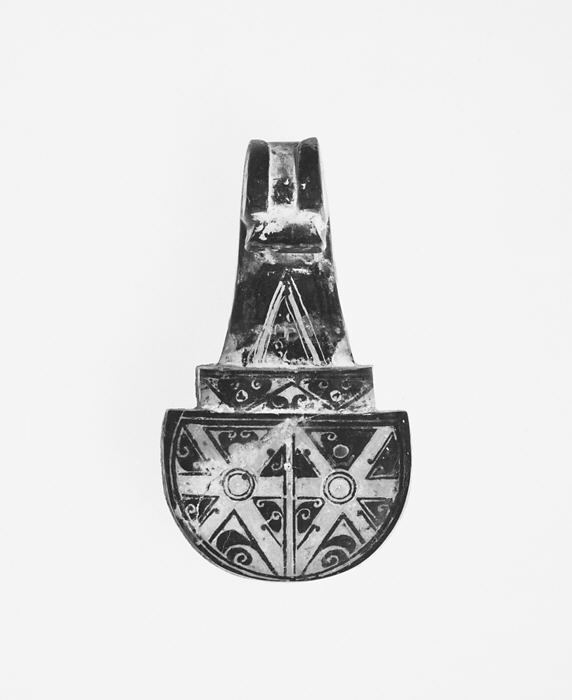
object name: model of a belthook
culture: chinese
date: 1901-2000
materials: earthenware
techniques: painting